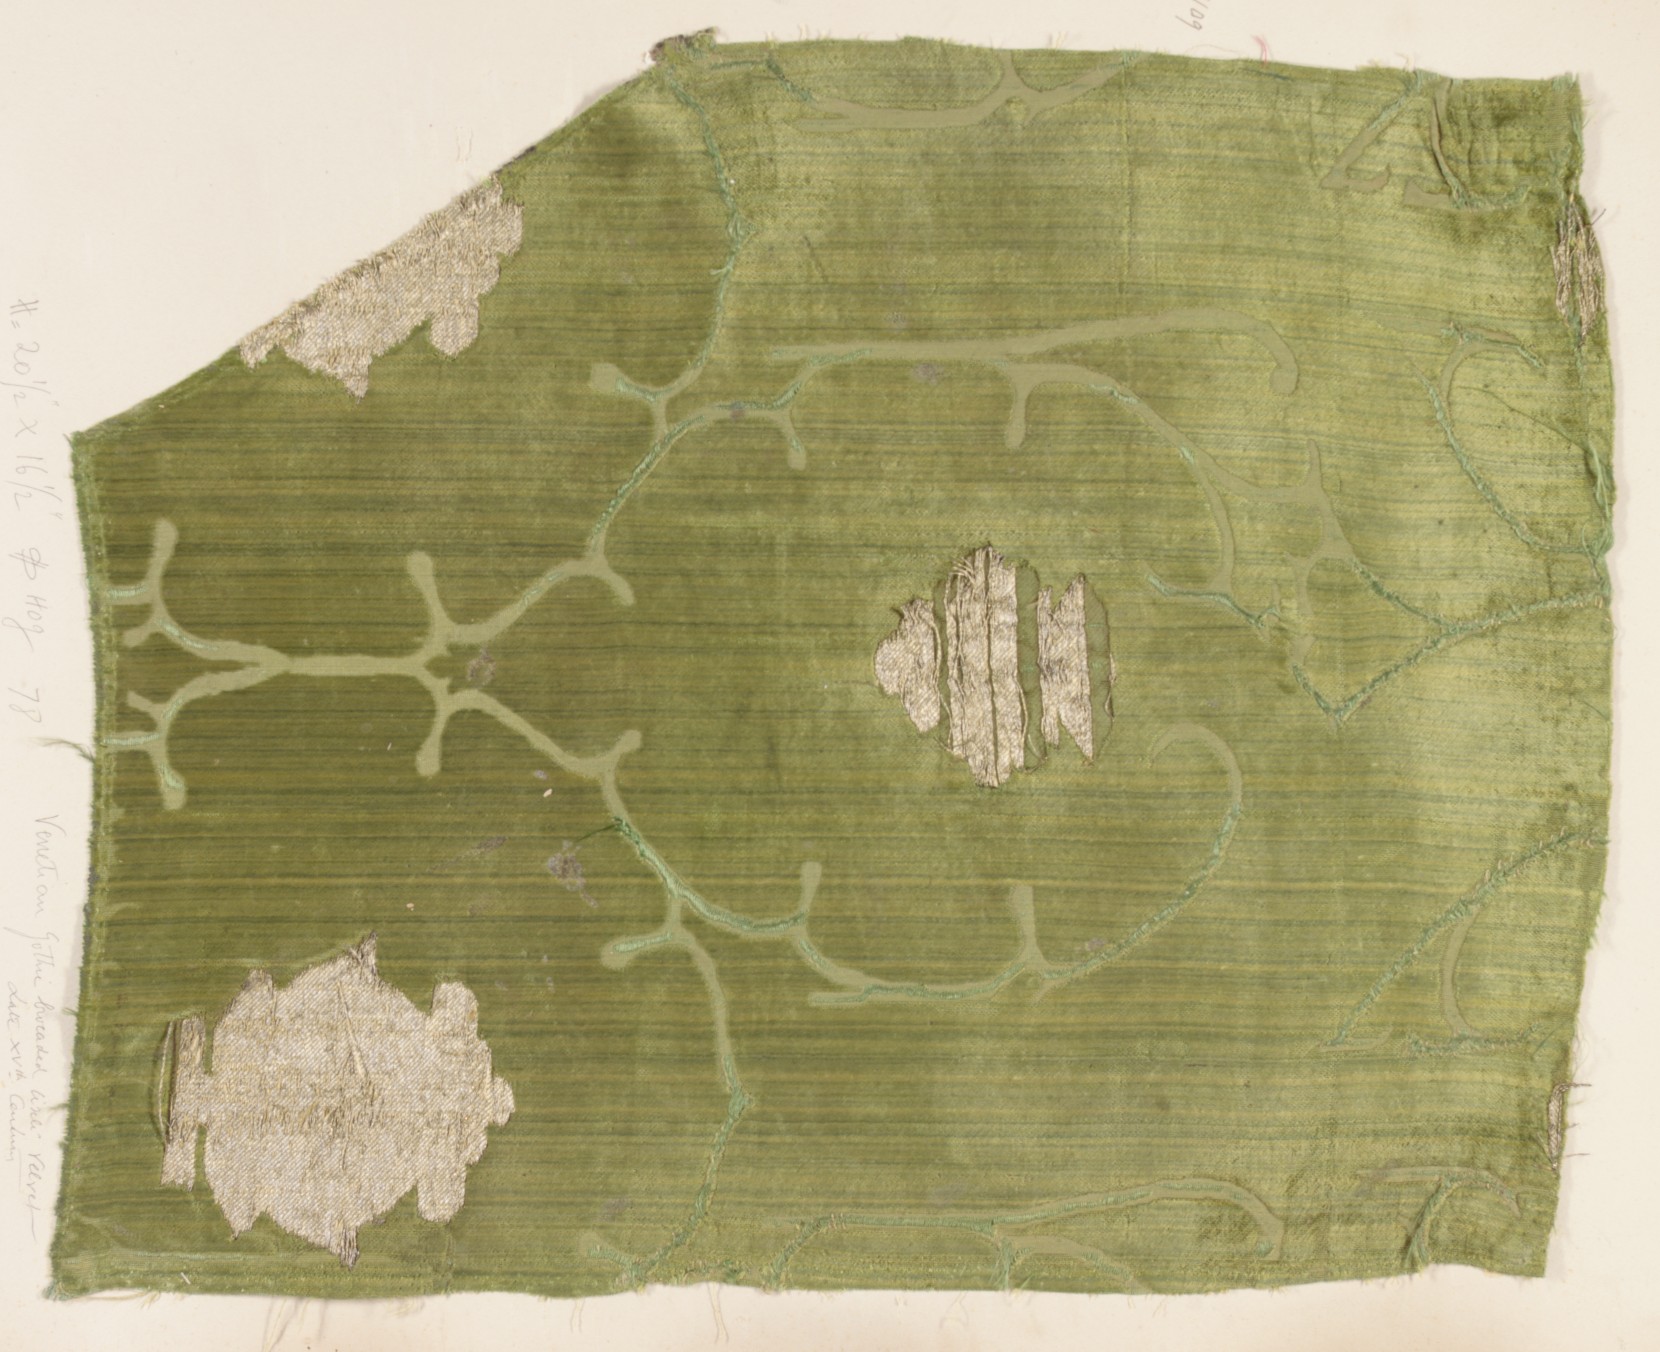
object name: fragment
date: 1467-1500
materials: metal thread, silk